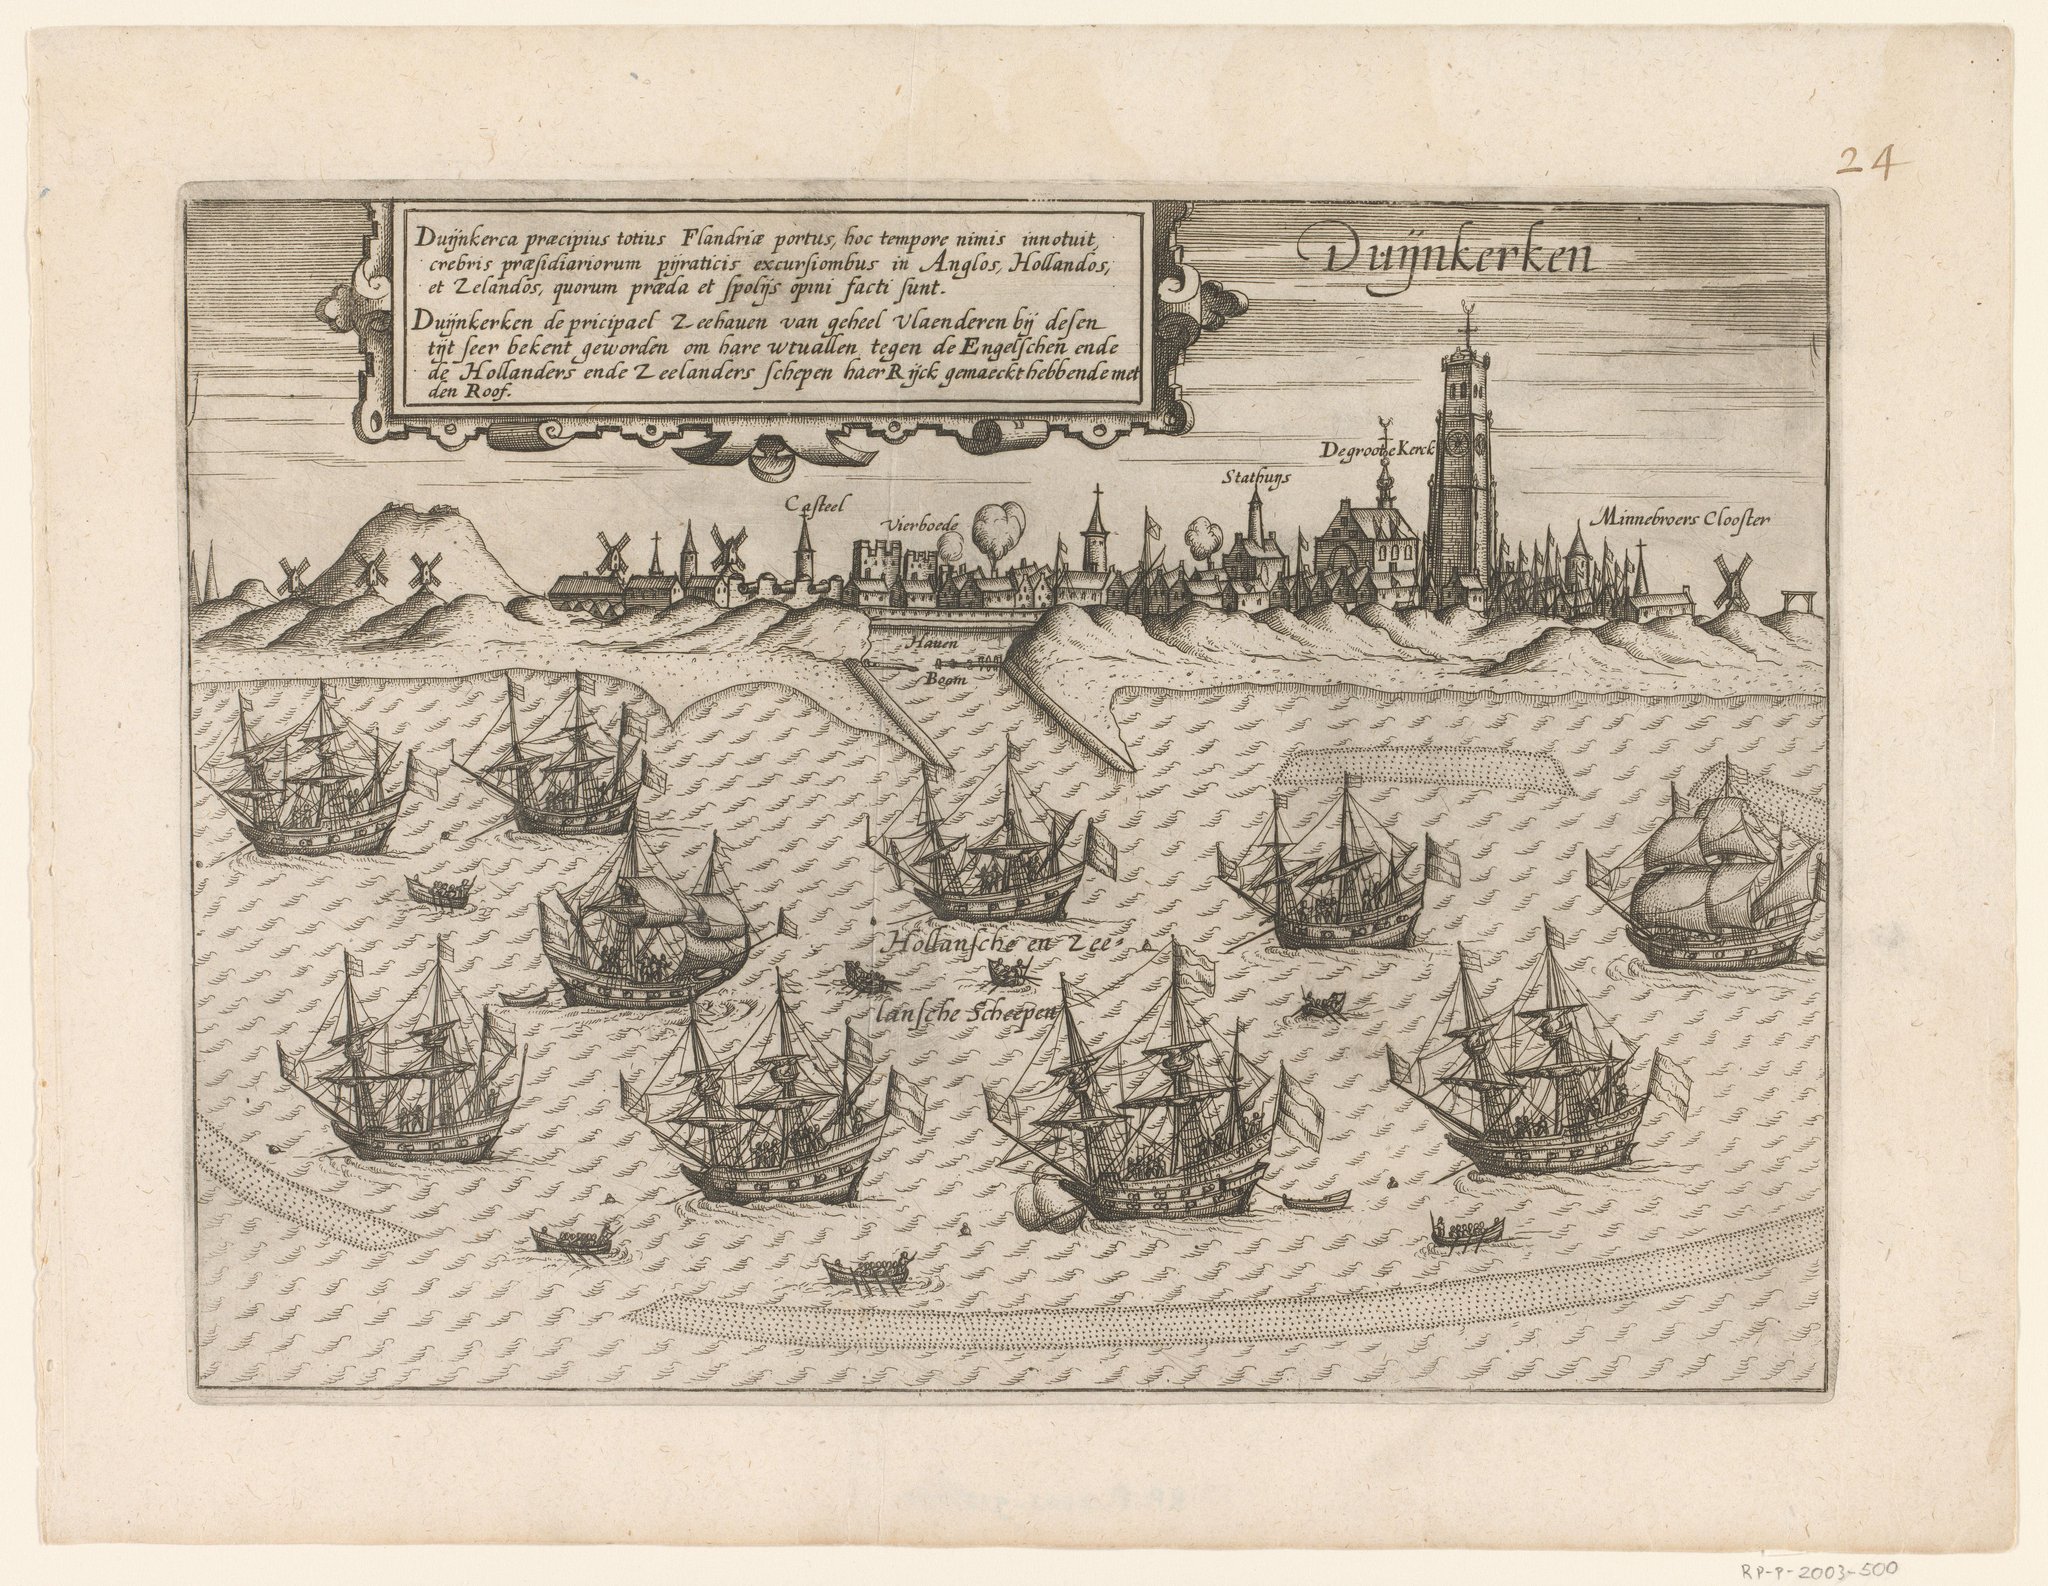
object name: print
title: Gezicht op Duinkerke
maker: Anonymous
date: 1607-1609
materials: paper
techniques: etching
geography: northern netherlands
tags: sailing-ship, sailing-boat, prospect of city, town panorama, silhouette of city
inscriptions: number: ‘24’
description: Gezicht op de stad Duinkerke (Dunkerque) vanaf het water. Rechtsboven de titel, linksboven een cartouche met tekst in het Frans en Nederlands. Voor de stad liggen tussen de zandbanken tien Hollandse en Zeeuwse schepen voor anker die de haven blokkeren. Onderdeel van de verzameling kaarten genomen uit een latere editie van: Descrittione di tutti i Paesi Bassi van Lodovico Guicciardini.